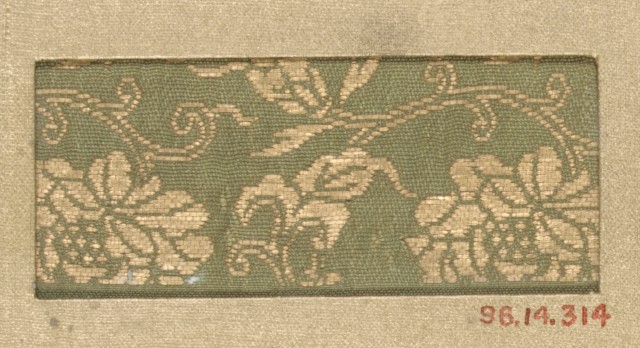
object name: piece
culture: japanese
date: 1701-1900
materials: silk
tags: flowers